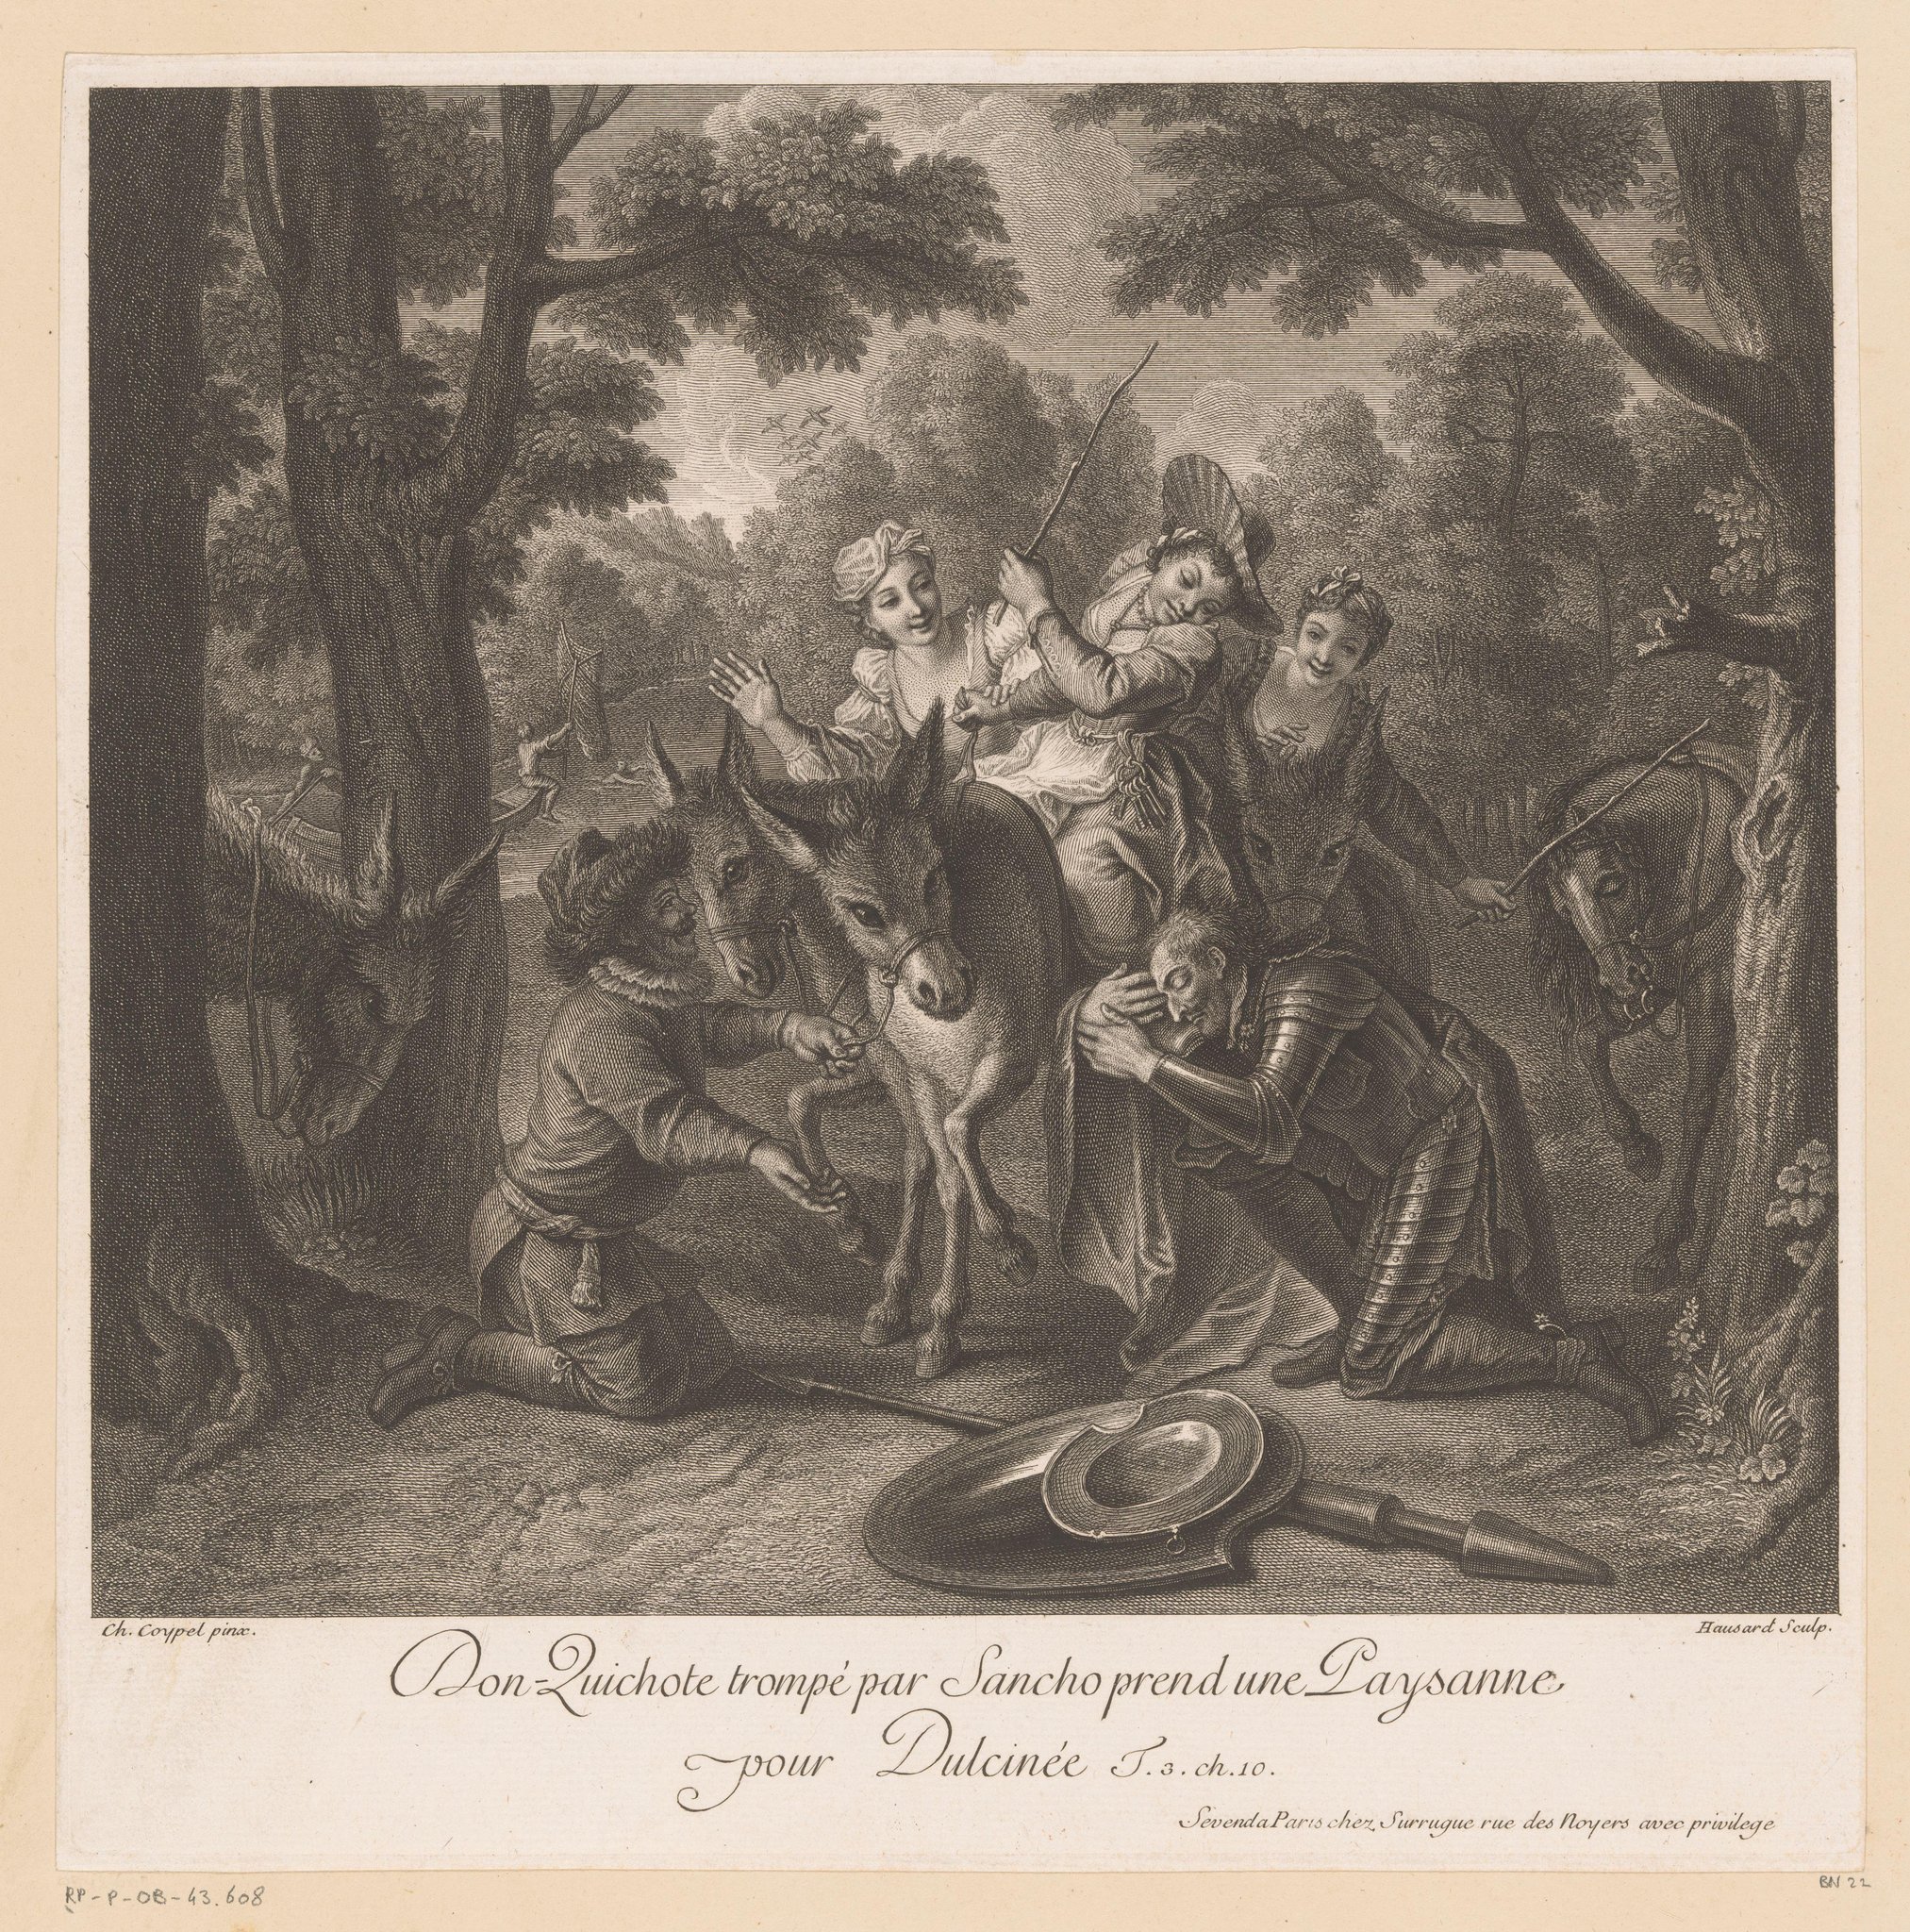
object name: print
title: Don Quichotte trompé par Sancho prend un paysanne pour Dulcinée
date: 1723-1736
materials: paper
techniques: engraving, etching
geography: paris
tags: ass, donkey, don quixote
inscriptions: collector's mark: Lugt 240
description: Maakt deel uit van een serie van 25 prenten met verschillende voorstellingen uit het verhaal van Don Quichot, naar ontwerpen door Coypel.